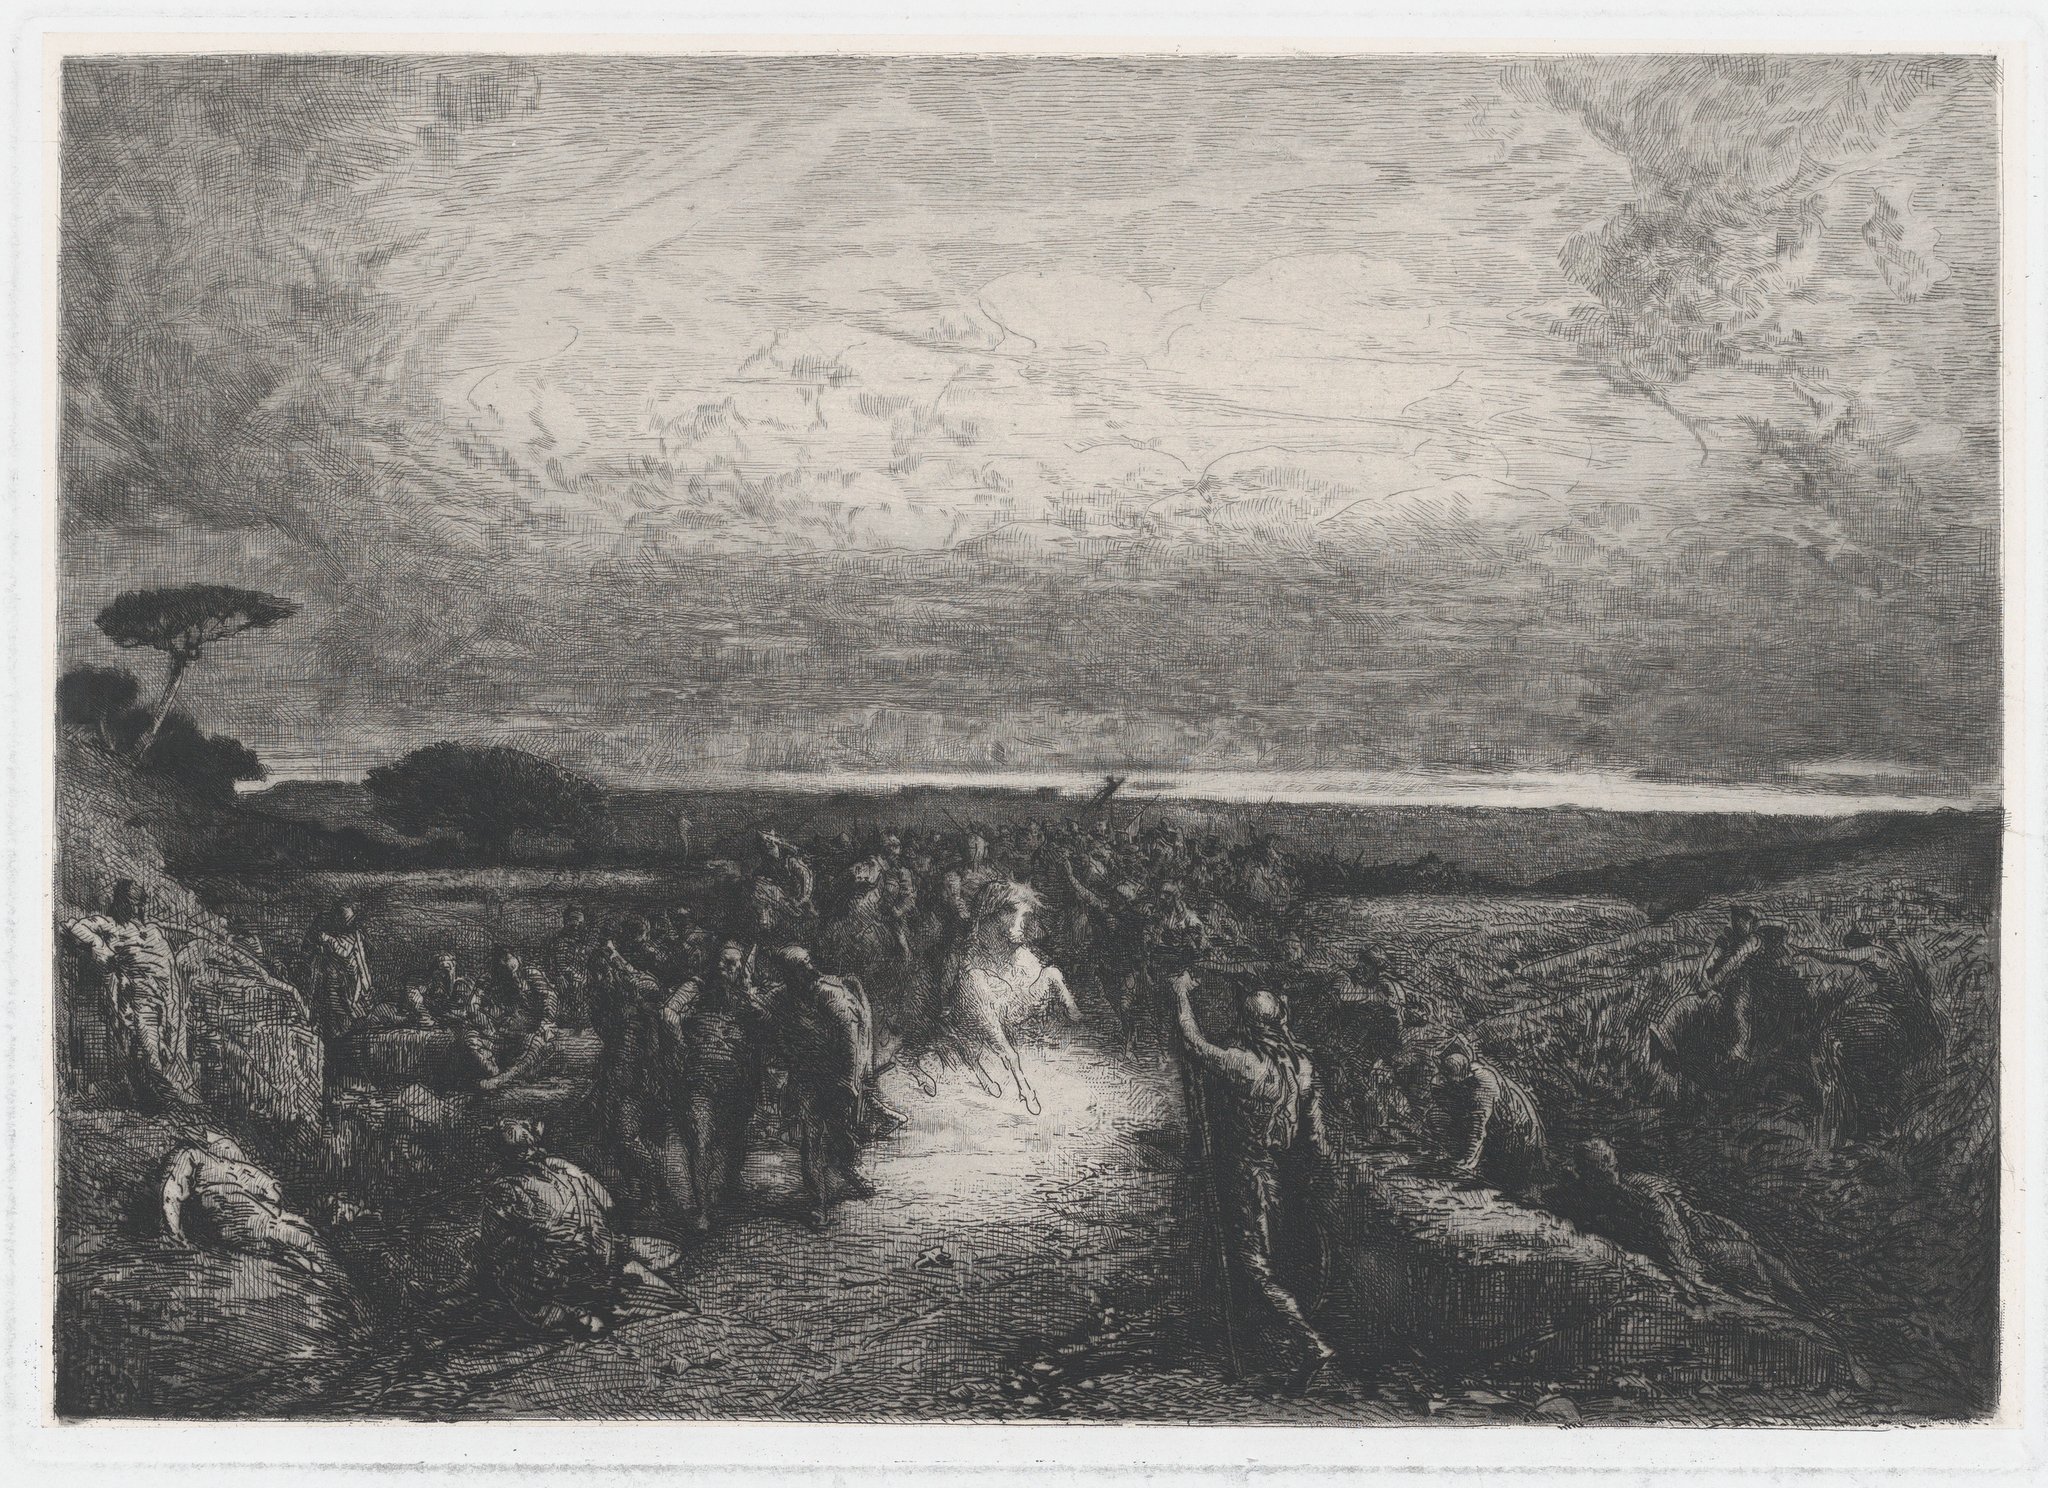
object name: print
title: Campagne de Rome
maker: françois-nicolas chifflart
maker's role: artist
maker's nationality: french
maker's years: 1825-1901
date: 1801-1900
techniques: etching